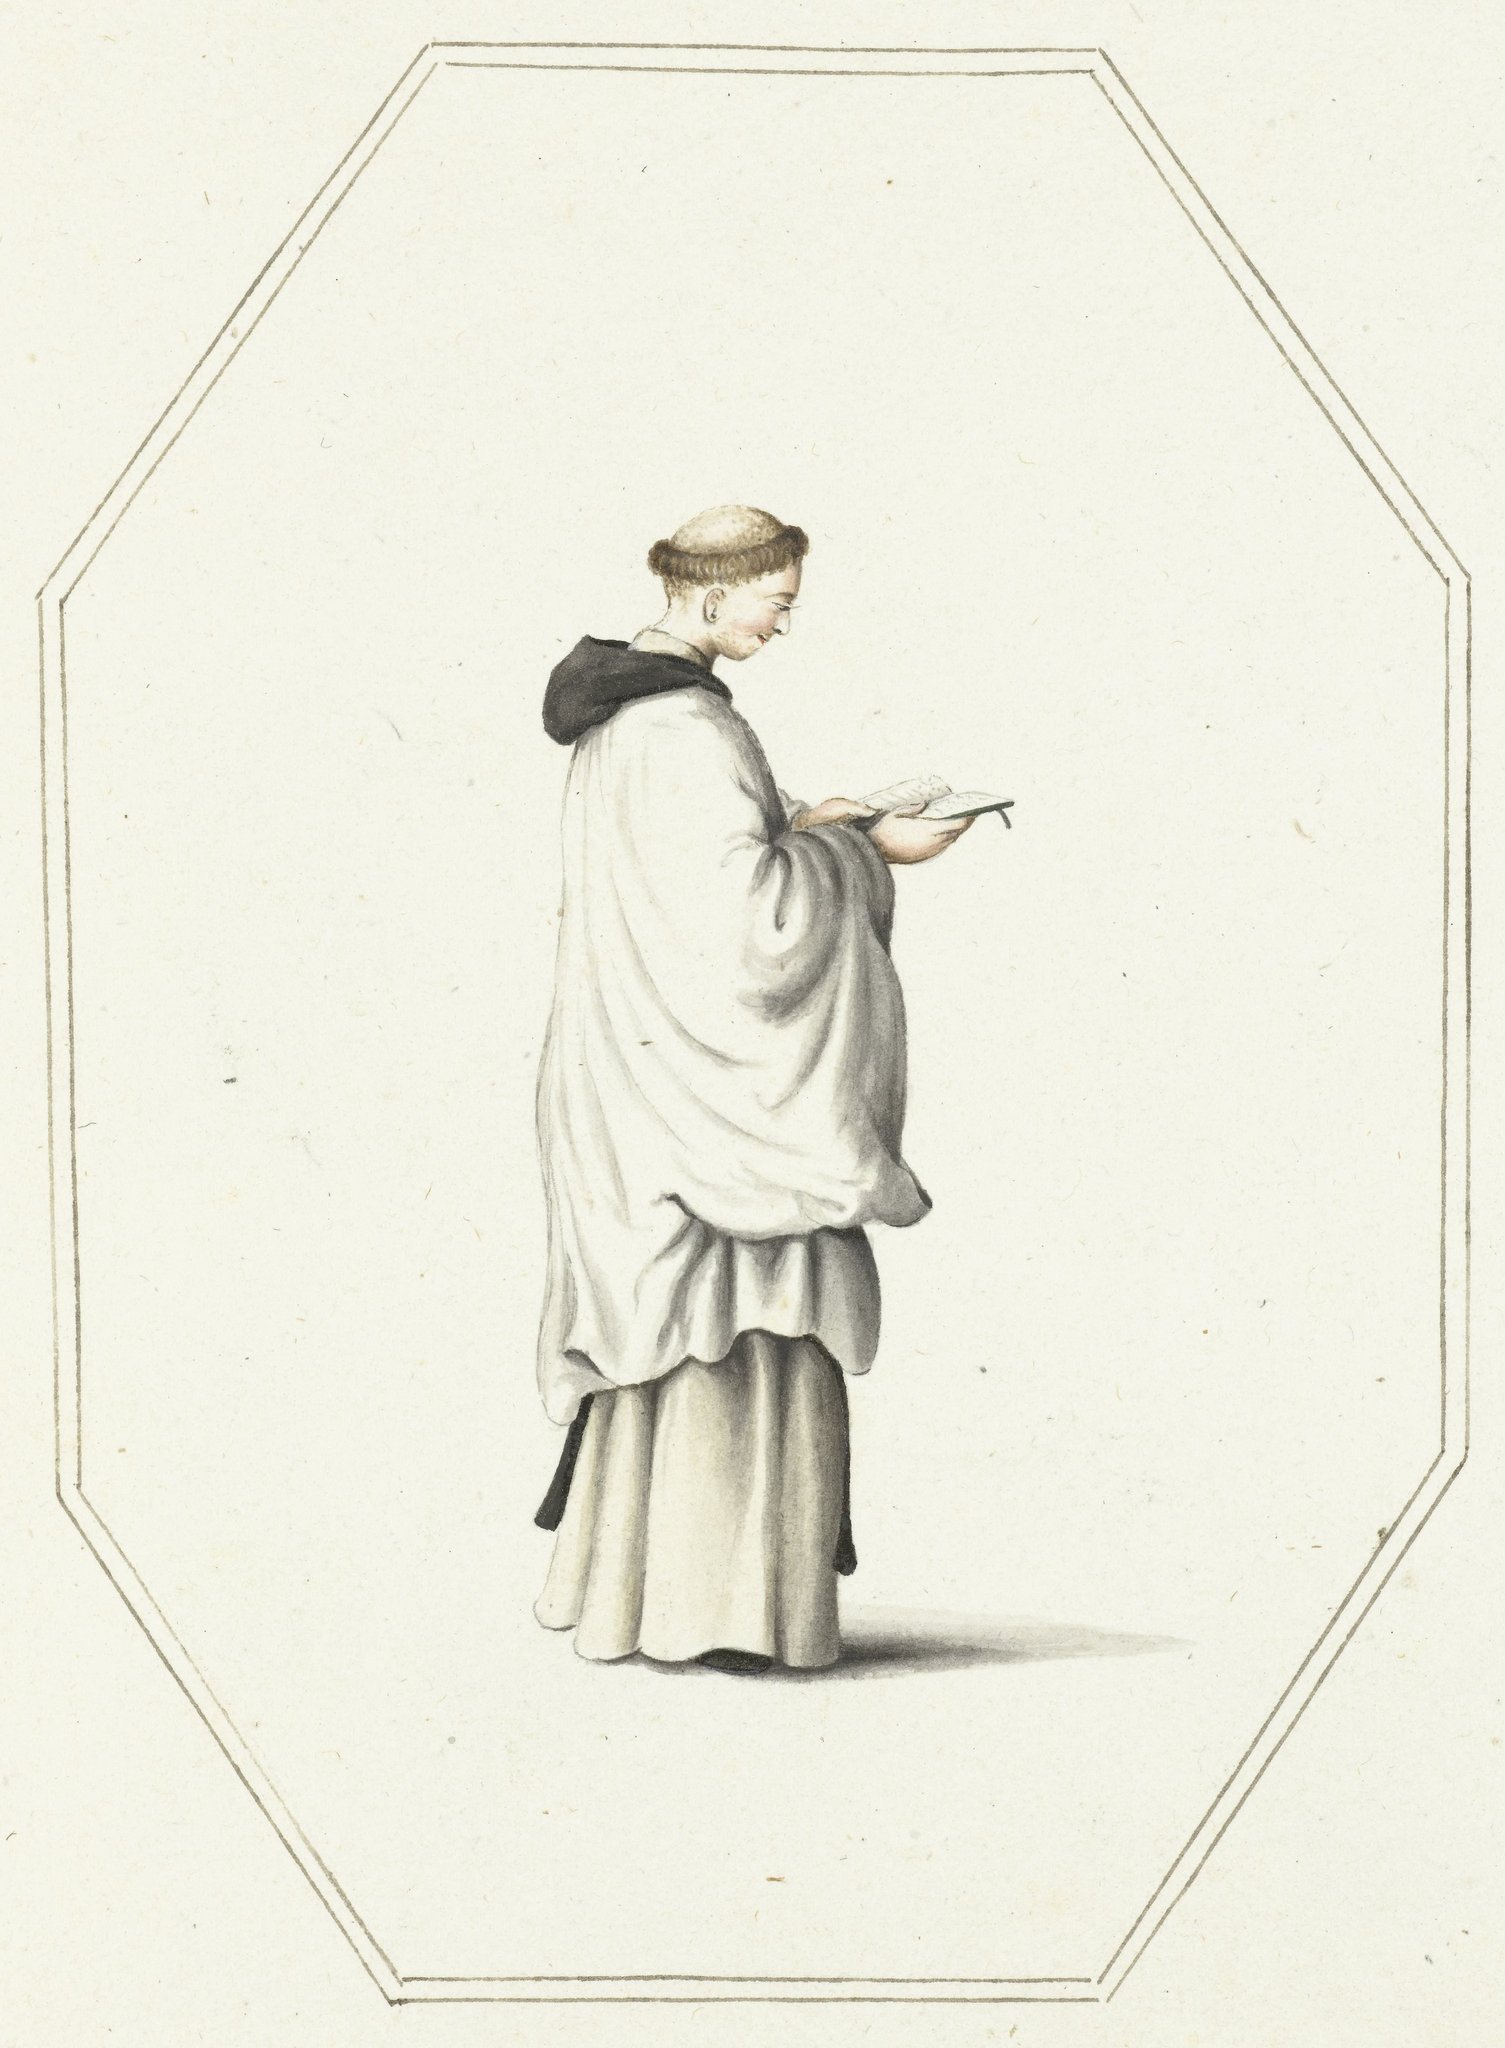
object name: watercolor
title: Lezende broeder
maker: gesina ter borch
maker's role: draughtsman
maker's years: 1633-1690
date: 1657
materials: paper, watercolor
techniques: brush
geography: zwolle